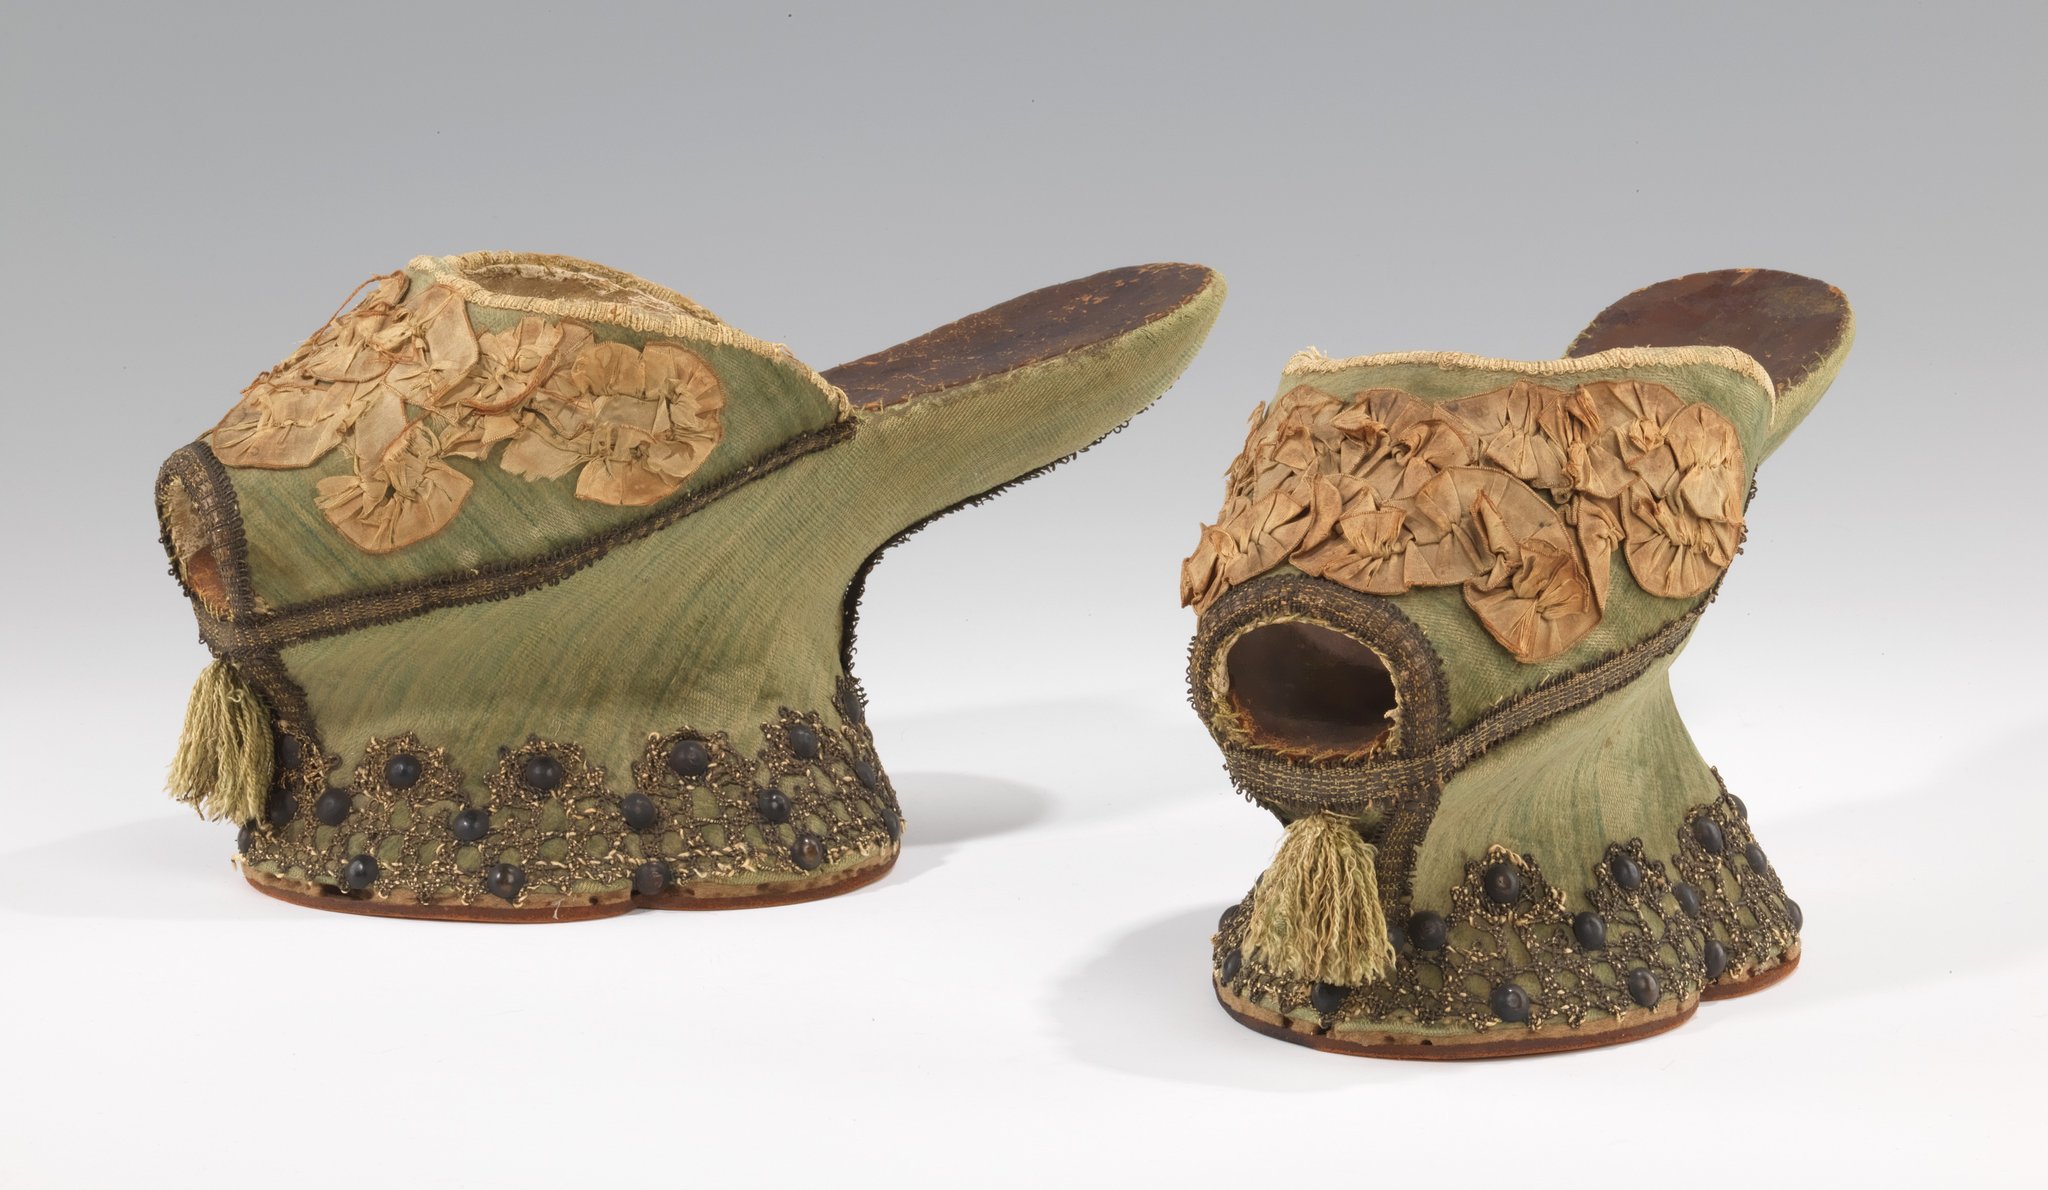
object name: chopine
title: Chopines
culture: italian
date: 1550-1650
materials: metal, silk